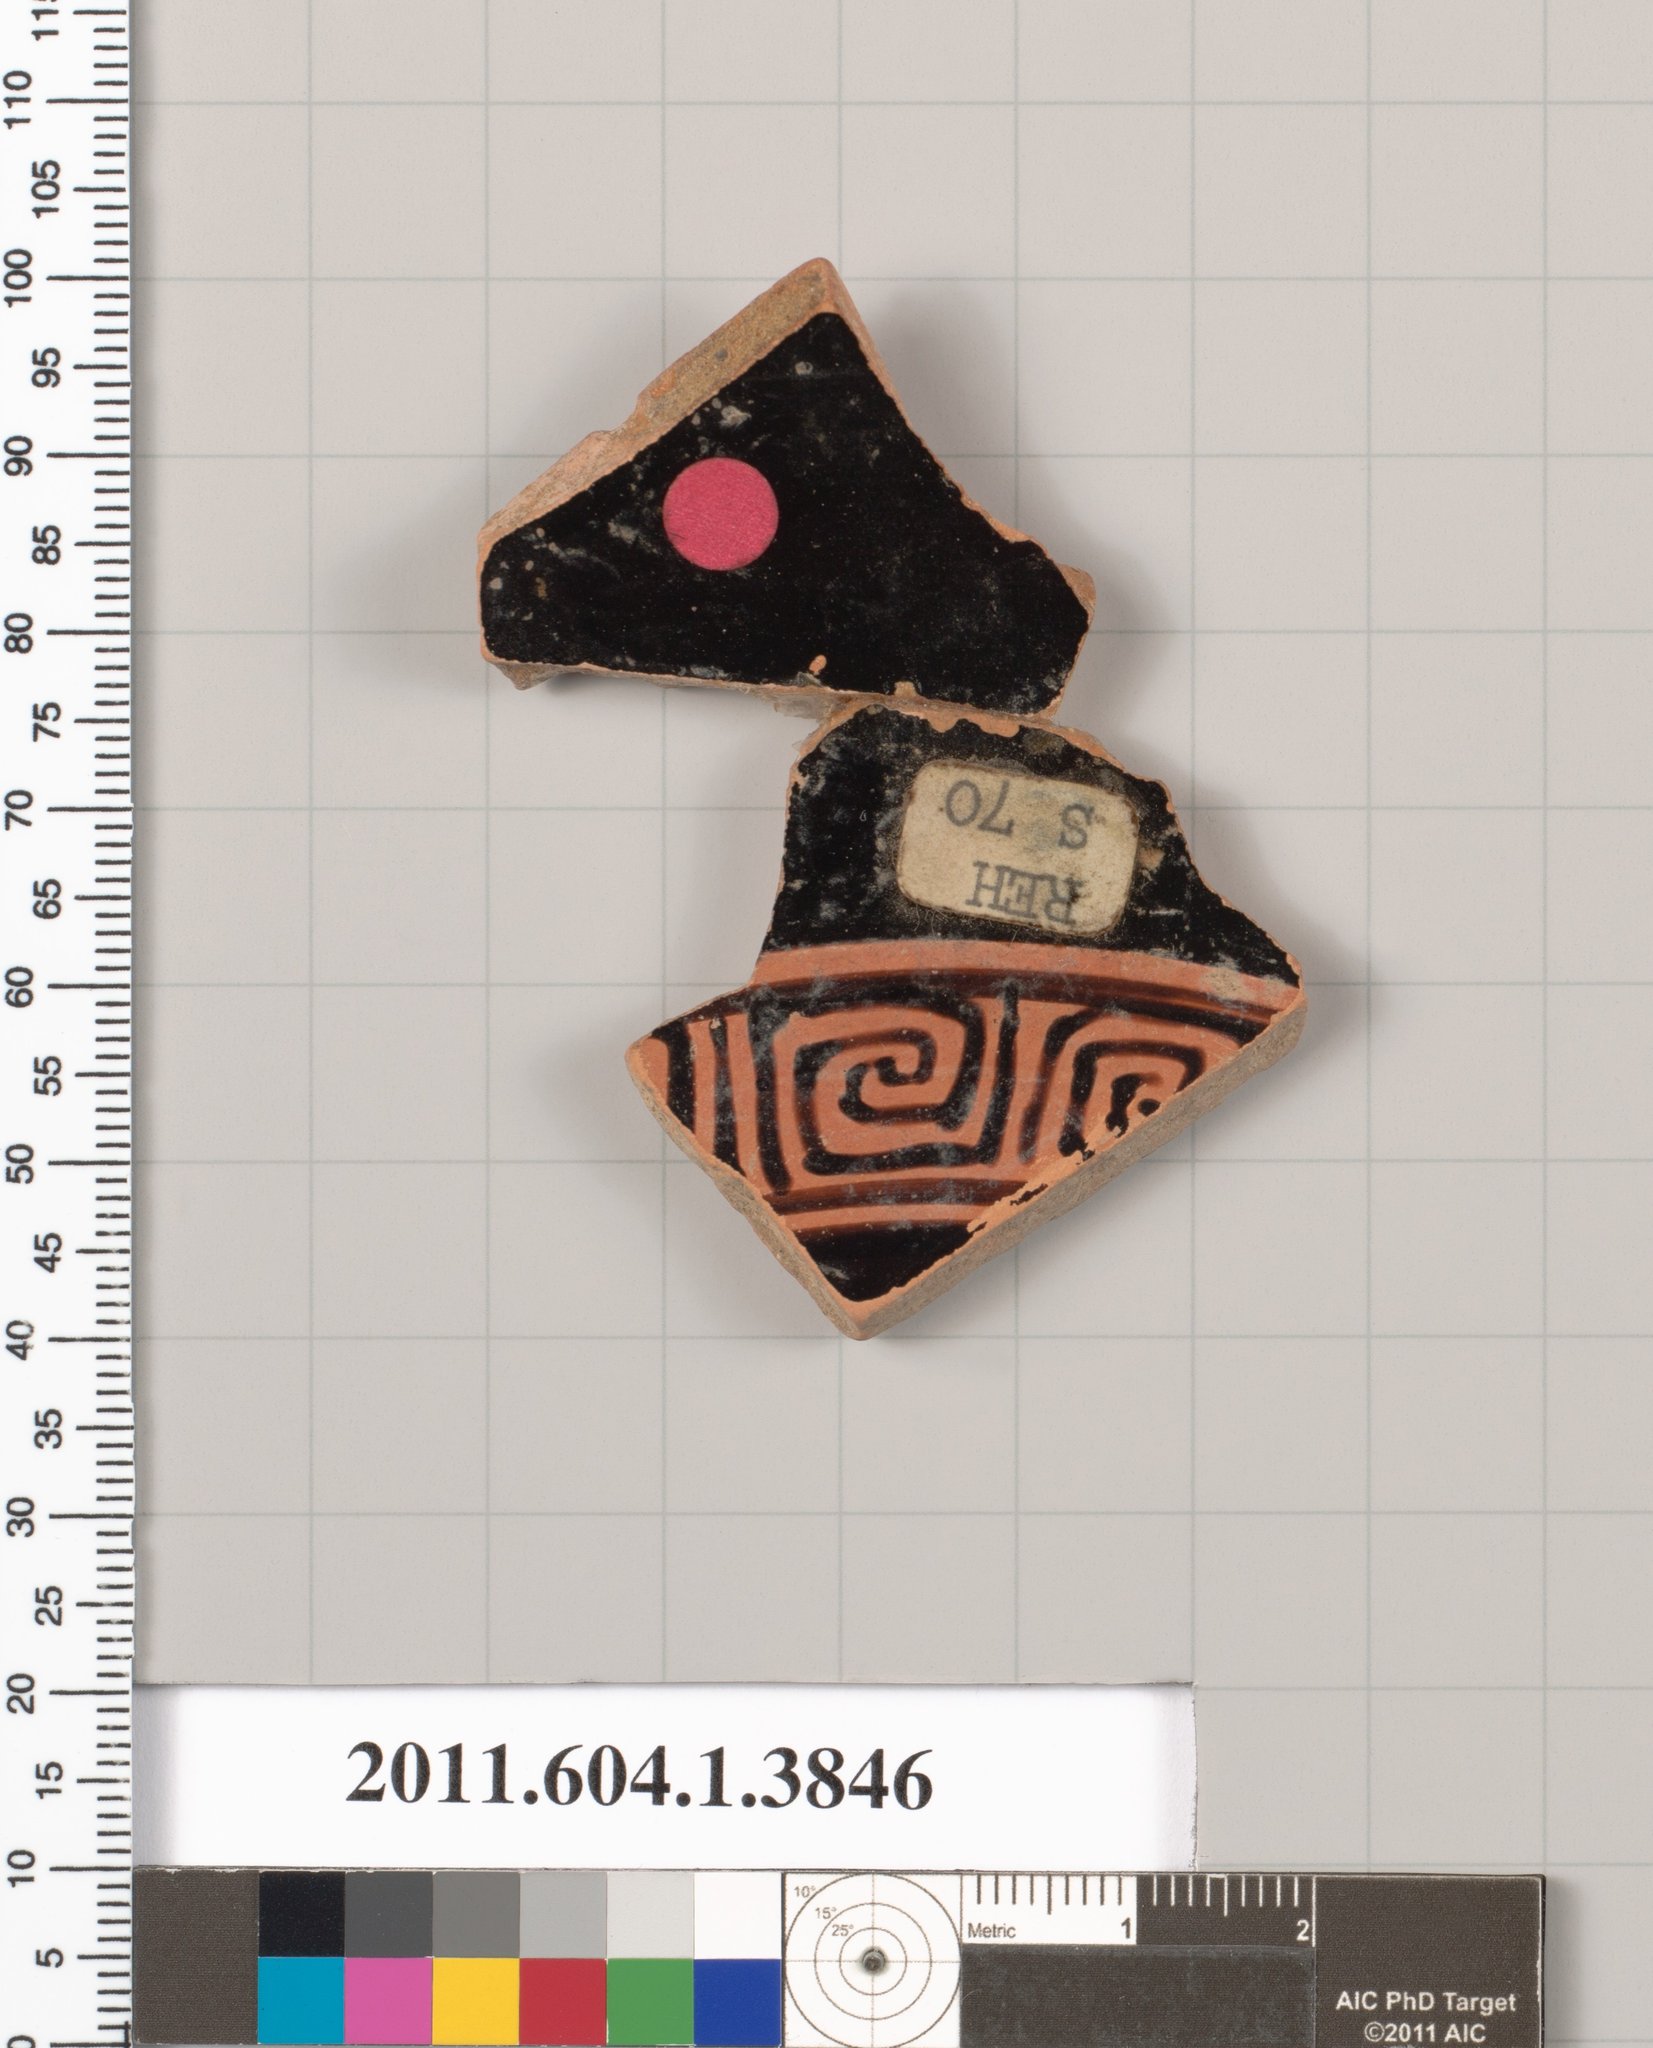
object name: kylix fragment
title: Terracotta fragment of a kylix (drinking cup)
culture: greek, attic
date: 450-426 BCE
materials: terracotta